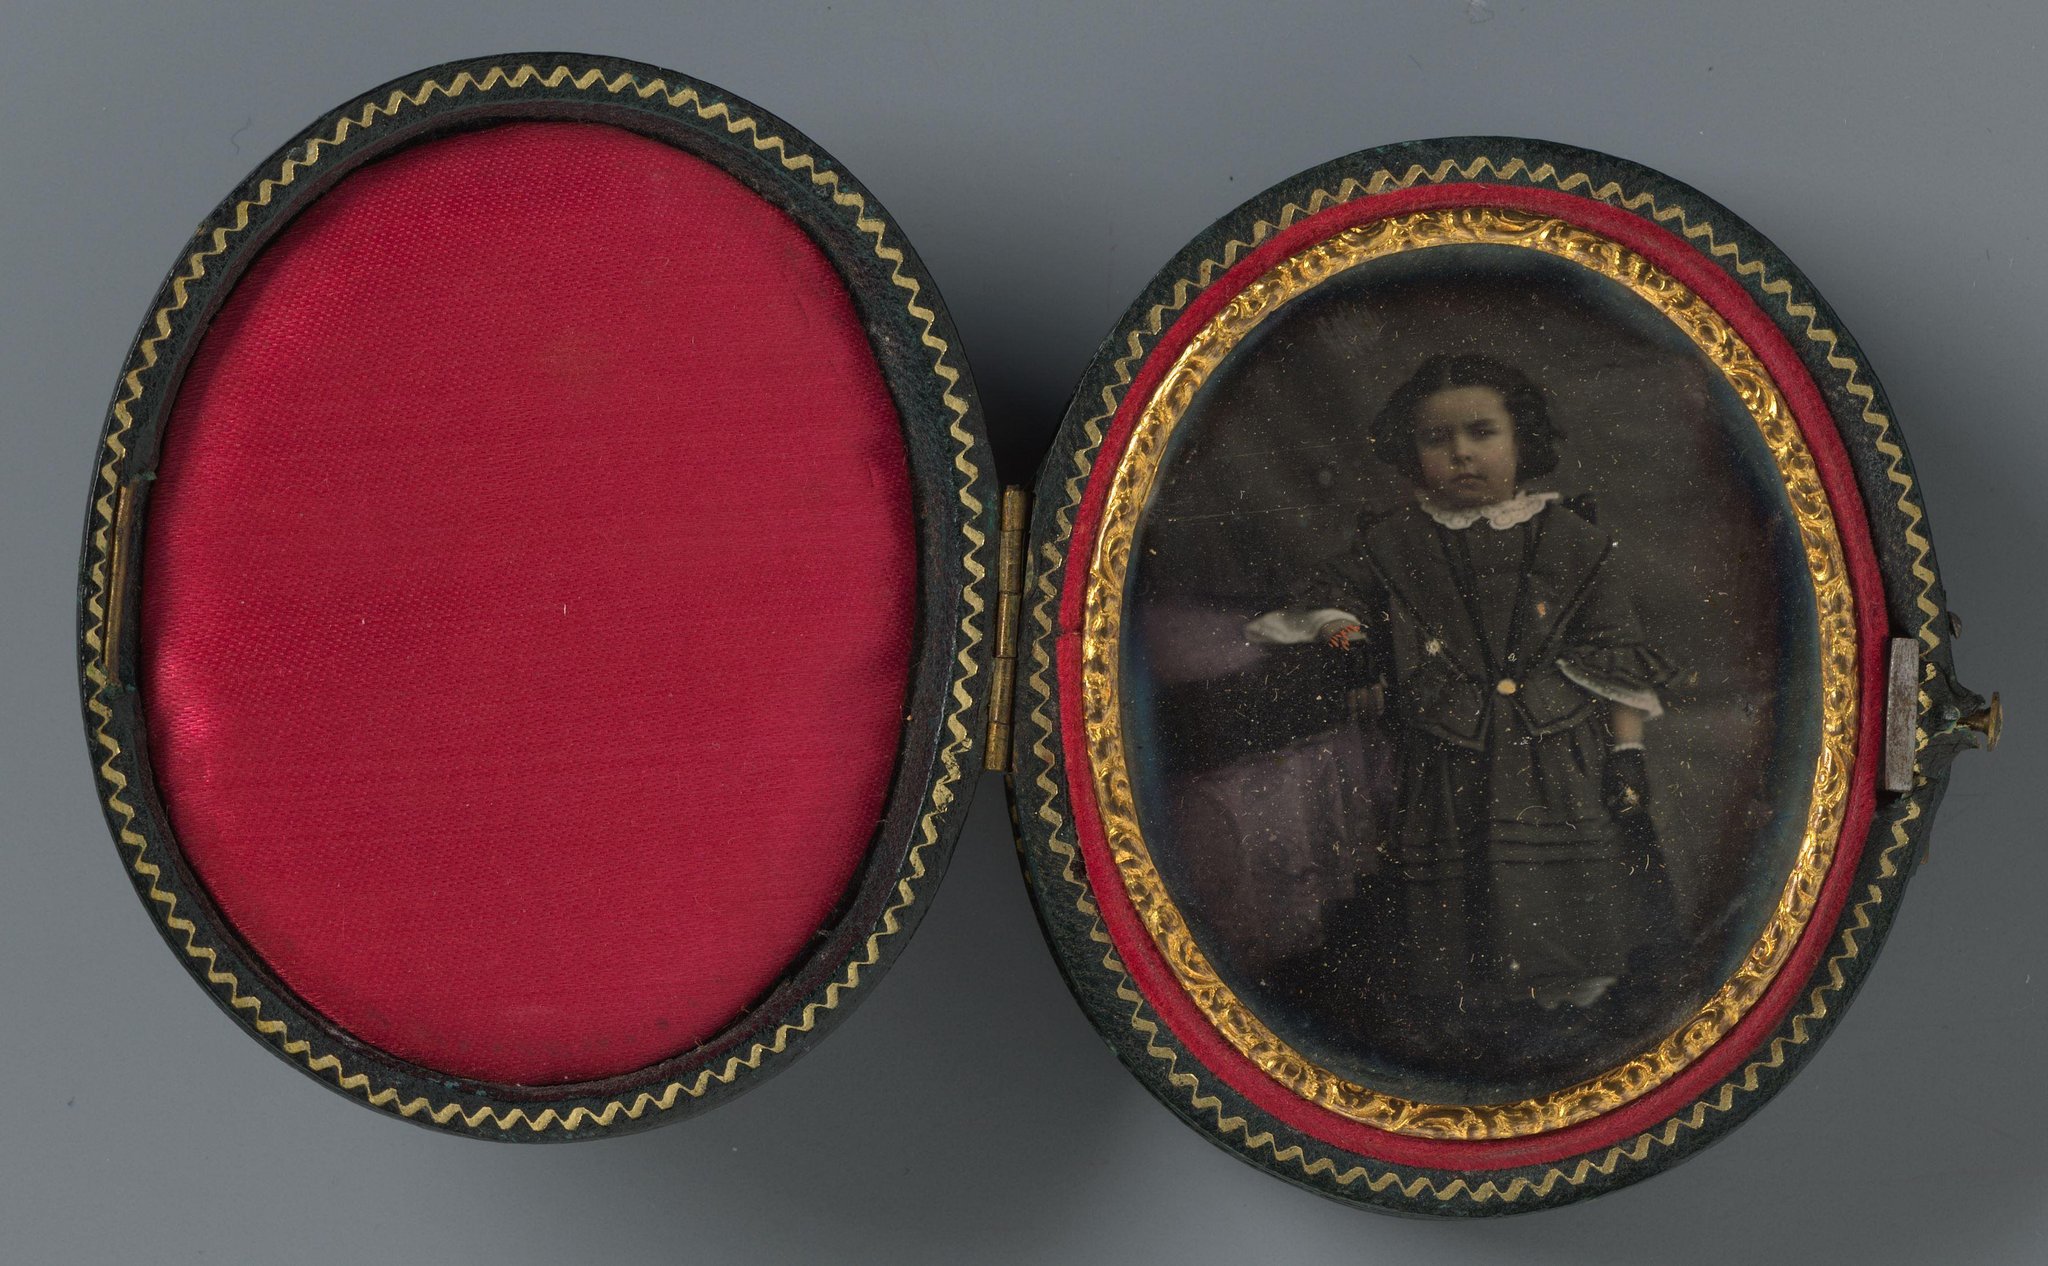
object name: photograph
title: Portret van een onbekend meisje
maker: Anonymous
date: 1840-1860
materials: copper, glass, leather, silk, velvet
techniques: daguerreotype, hand coloring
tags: historical persons, girl (child between toddler and youth)